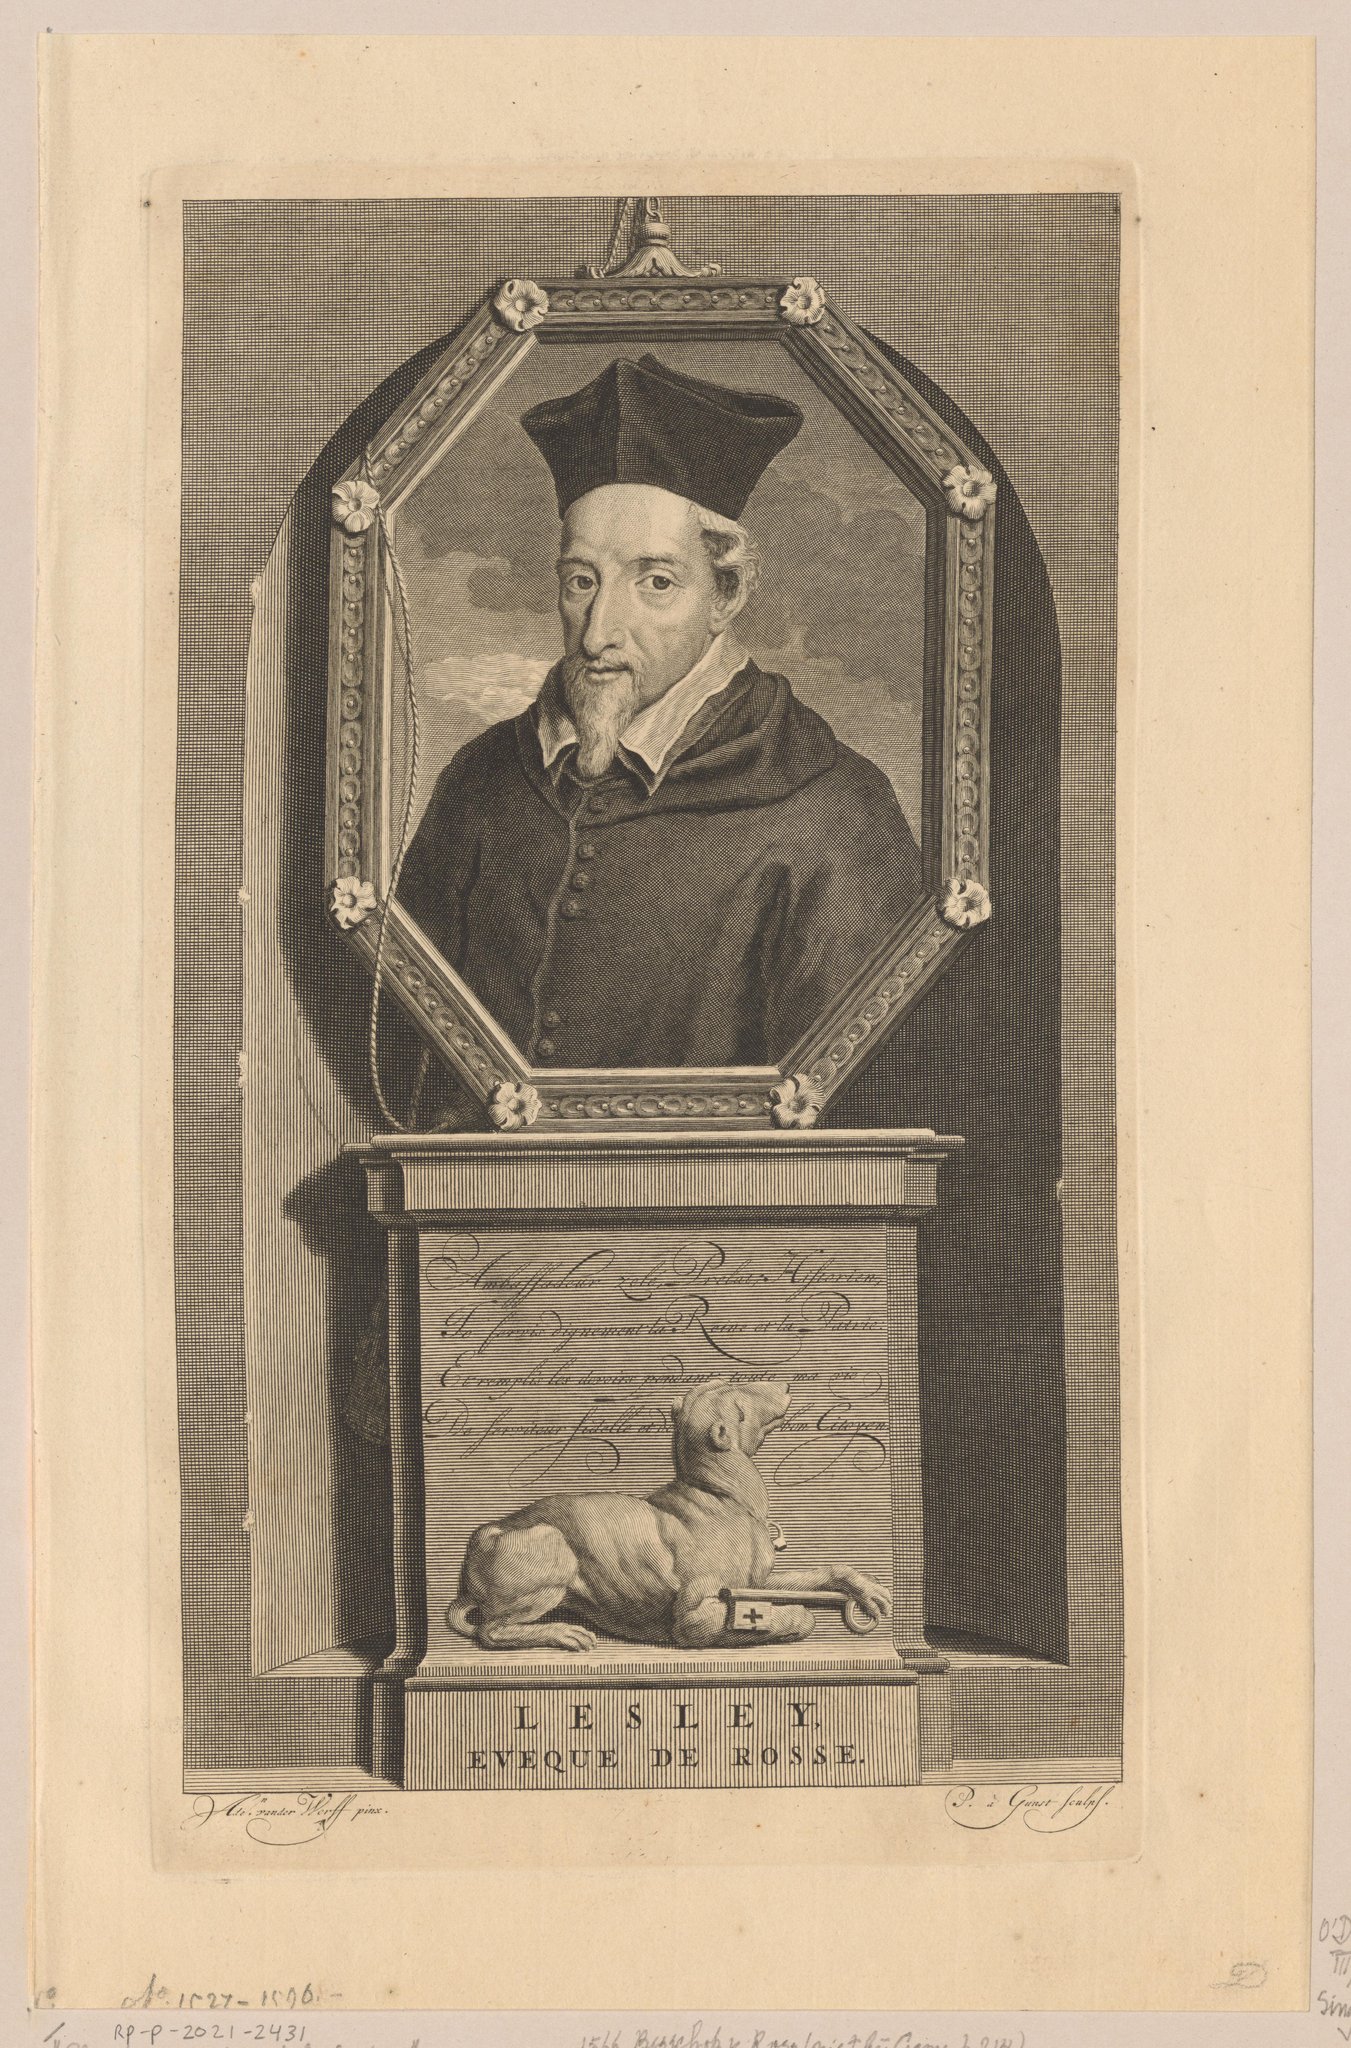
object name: print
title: Portret van John Lesley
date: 1698-1707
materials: paper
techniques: engraving, etching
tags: archbishop, bishop, etc. (roman catholic), ornament ~ medallion, historical persons, key, dog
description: Prent waarschijnlijk uit: Larrey, Isaac de. Histoire d'Angleterre, d'Ecosse, et d'Irlande (...). Rotterdam: Reinier Leers, 1698, dl. 2. Of uit de editie uit 1707.